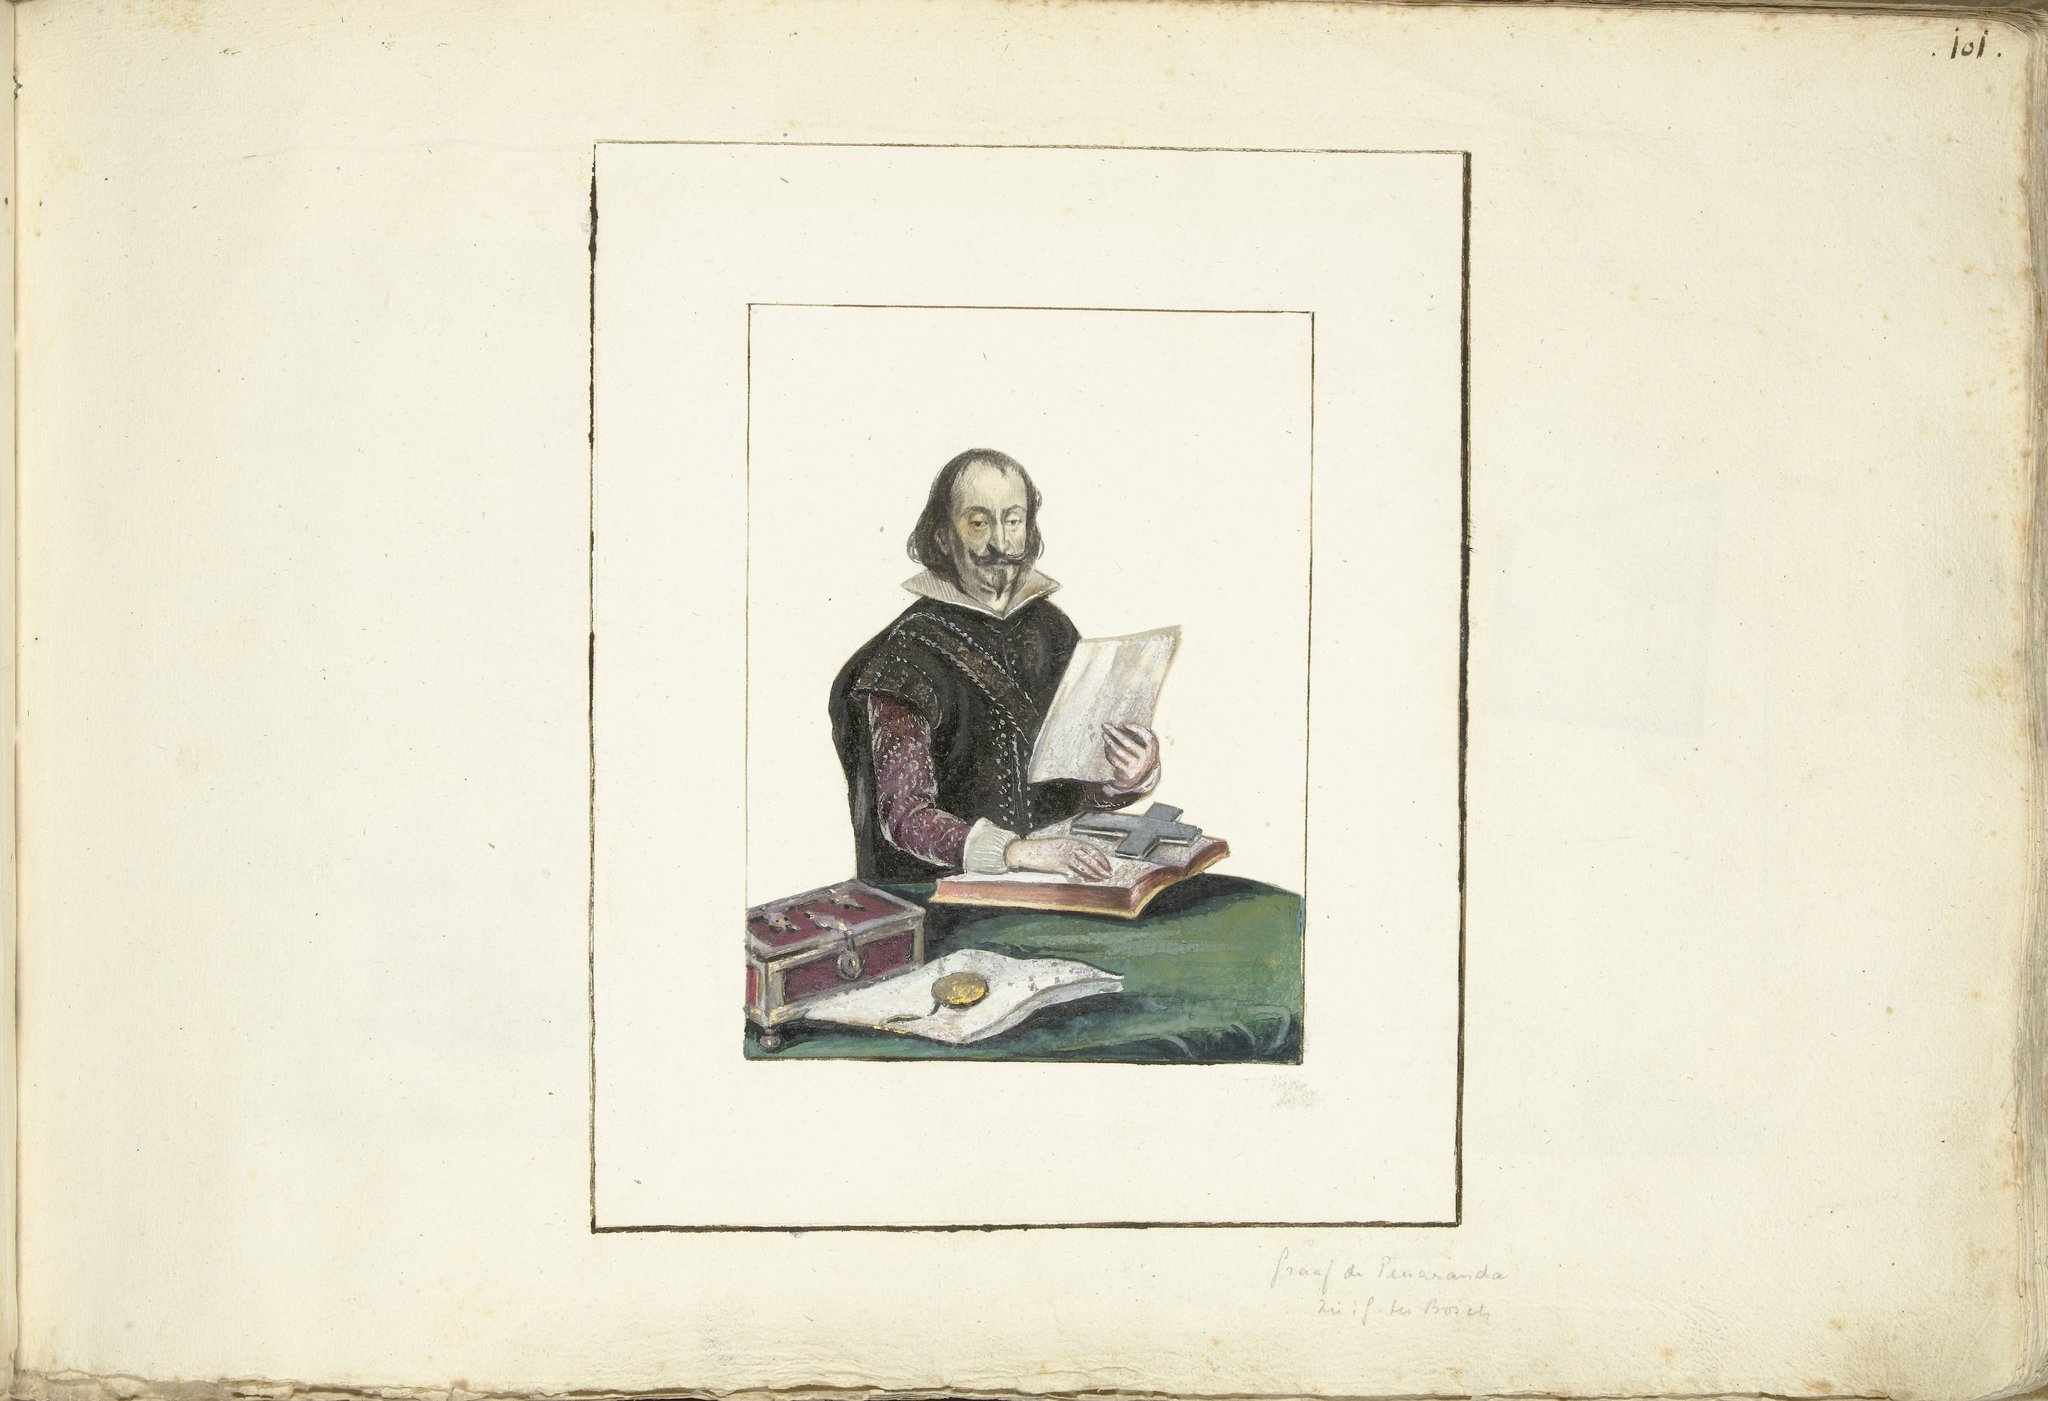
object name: drawing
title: Portret van de Graaf van Peñeranda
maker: gesina ter borch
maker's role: draughtsman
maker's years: 1633-1690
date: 1648-1687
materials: paper, watercolor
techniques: brush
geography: munster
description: Kopie naar schilderij De Vrede van Münster van Gerard ter Borch de Jonge uit 1648. Het portret is opgeplakt op een blad papier dat weer in het Familie-plakboek is geplakt.